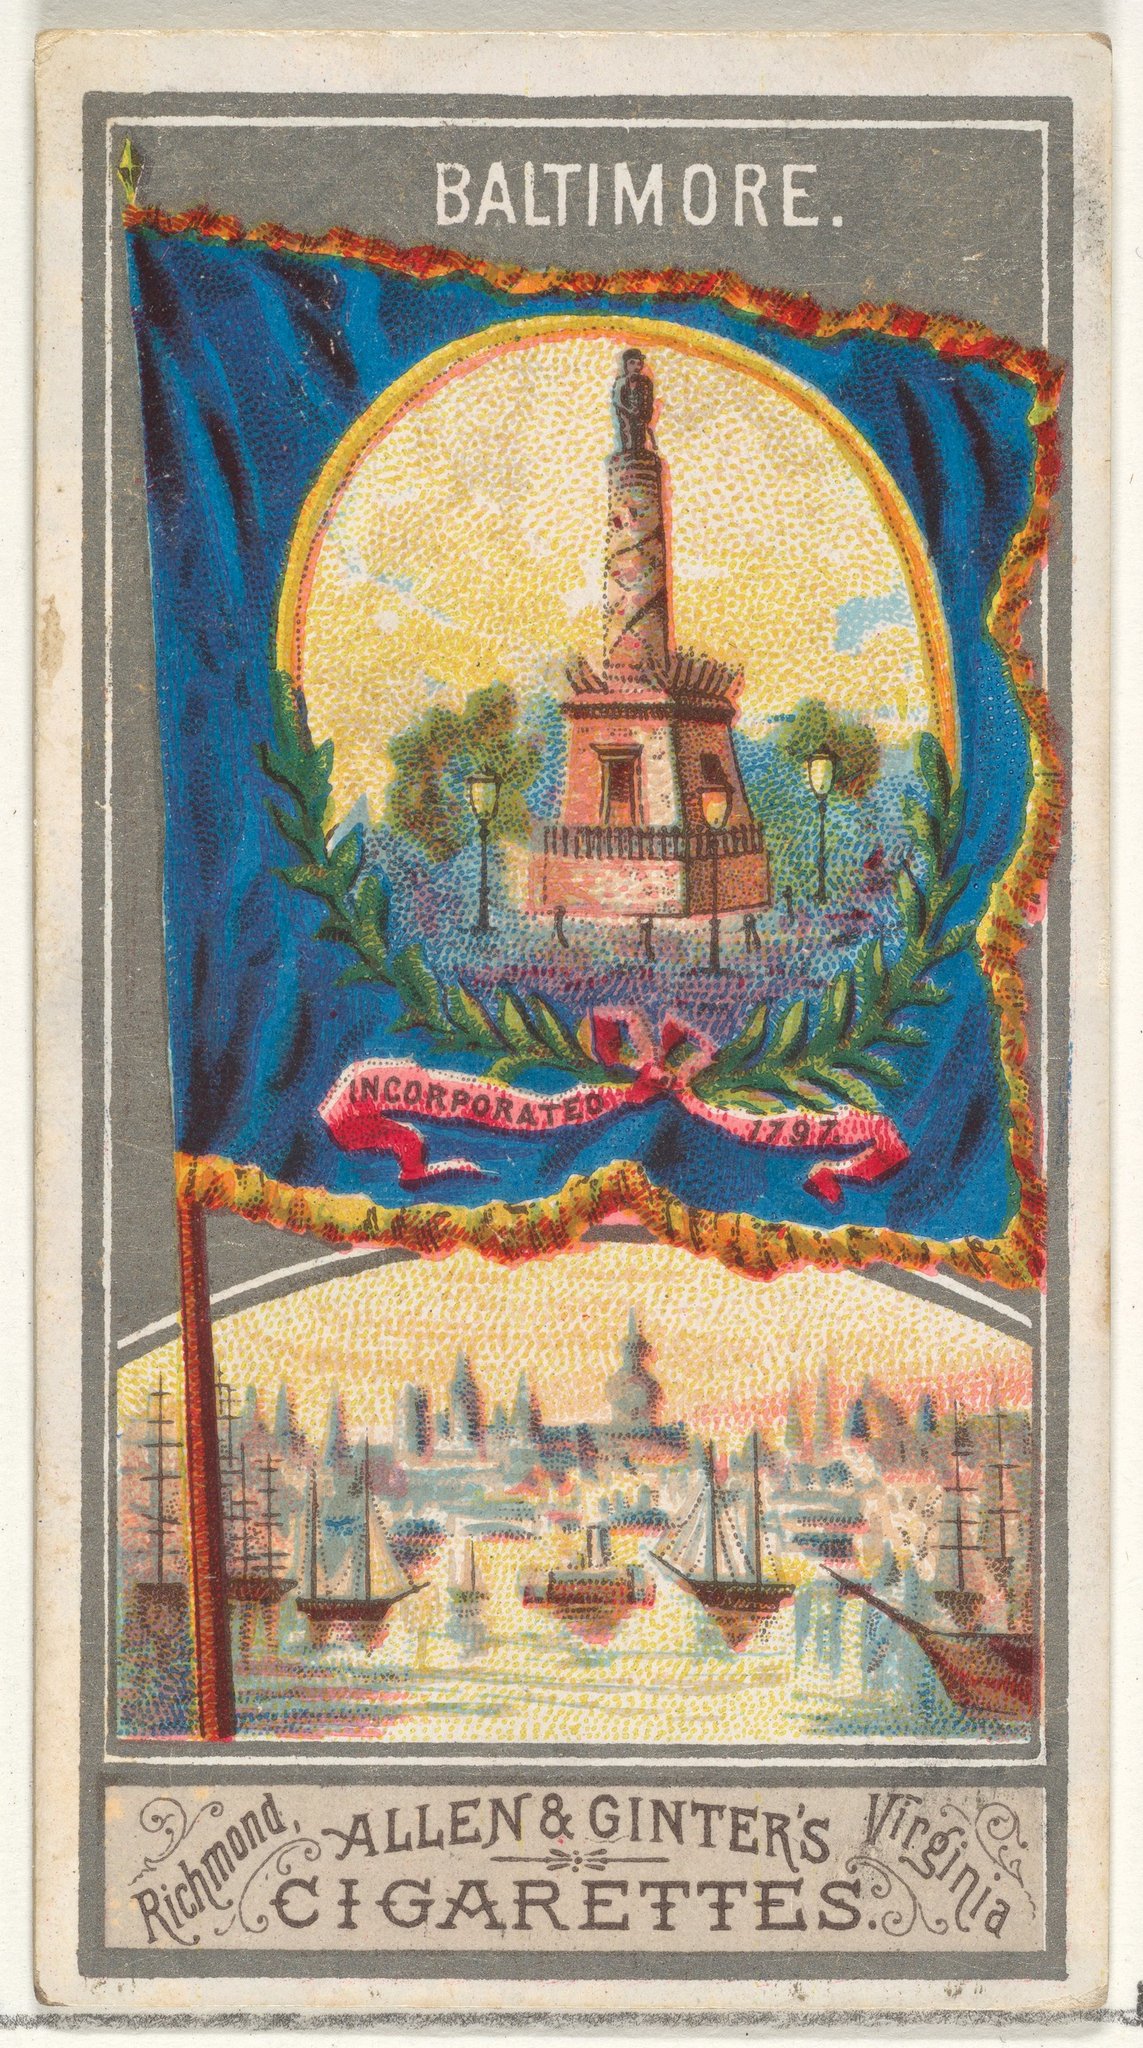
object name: print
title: Baltimore, from the City Flags series (N6) for Allen & Ginter Cigarettes Brands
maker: allen & ginter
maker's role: publisher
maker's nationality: american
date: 1887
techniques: color lithograph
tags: cities,flags,ships